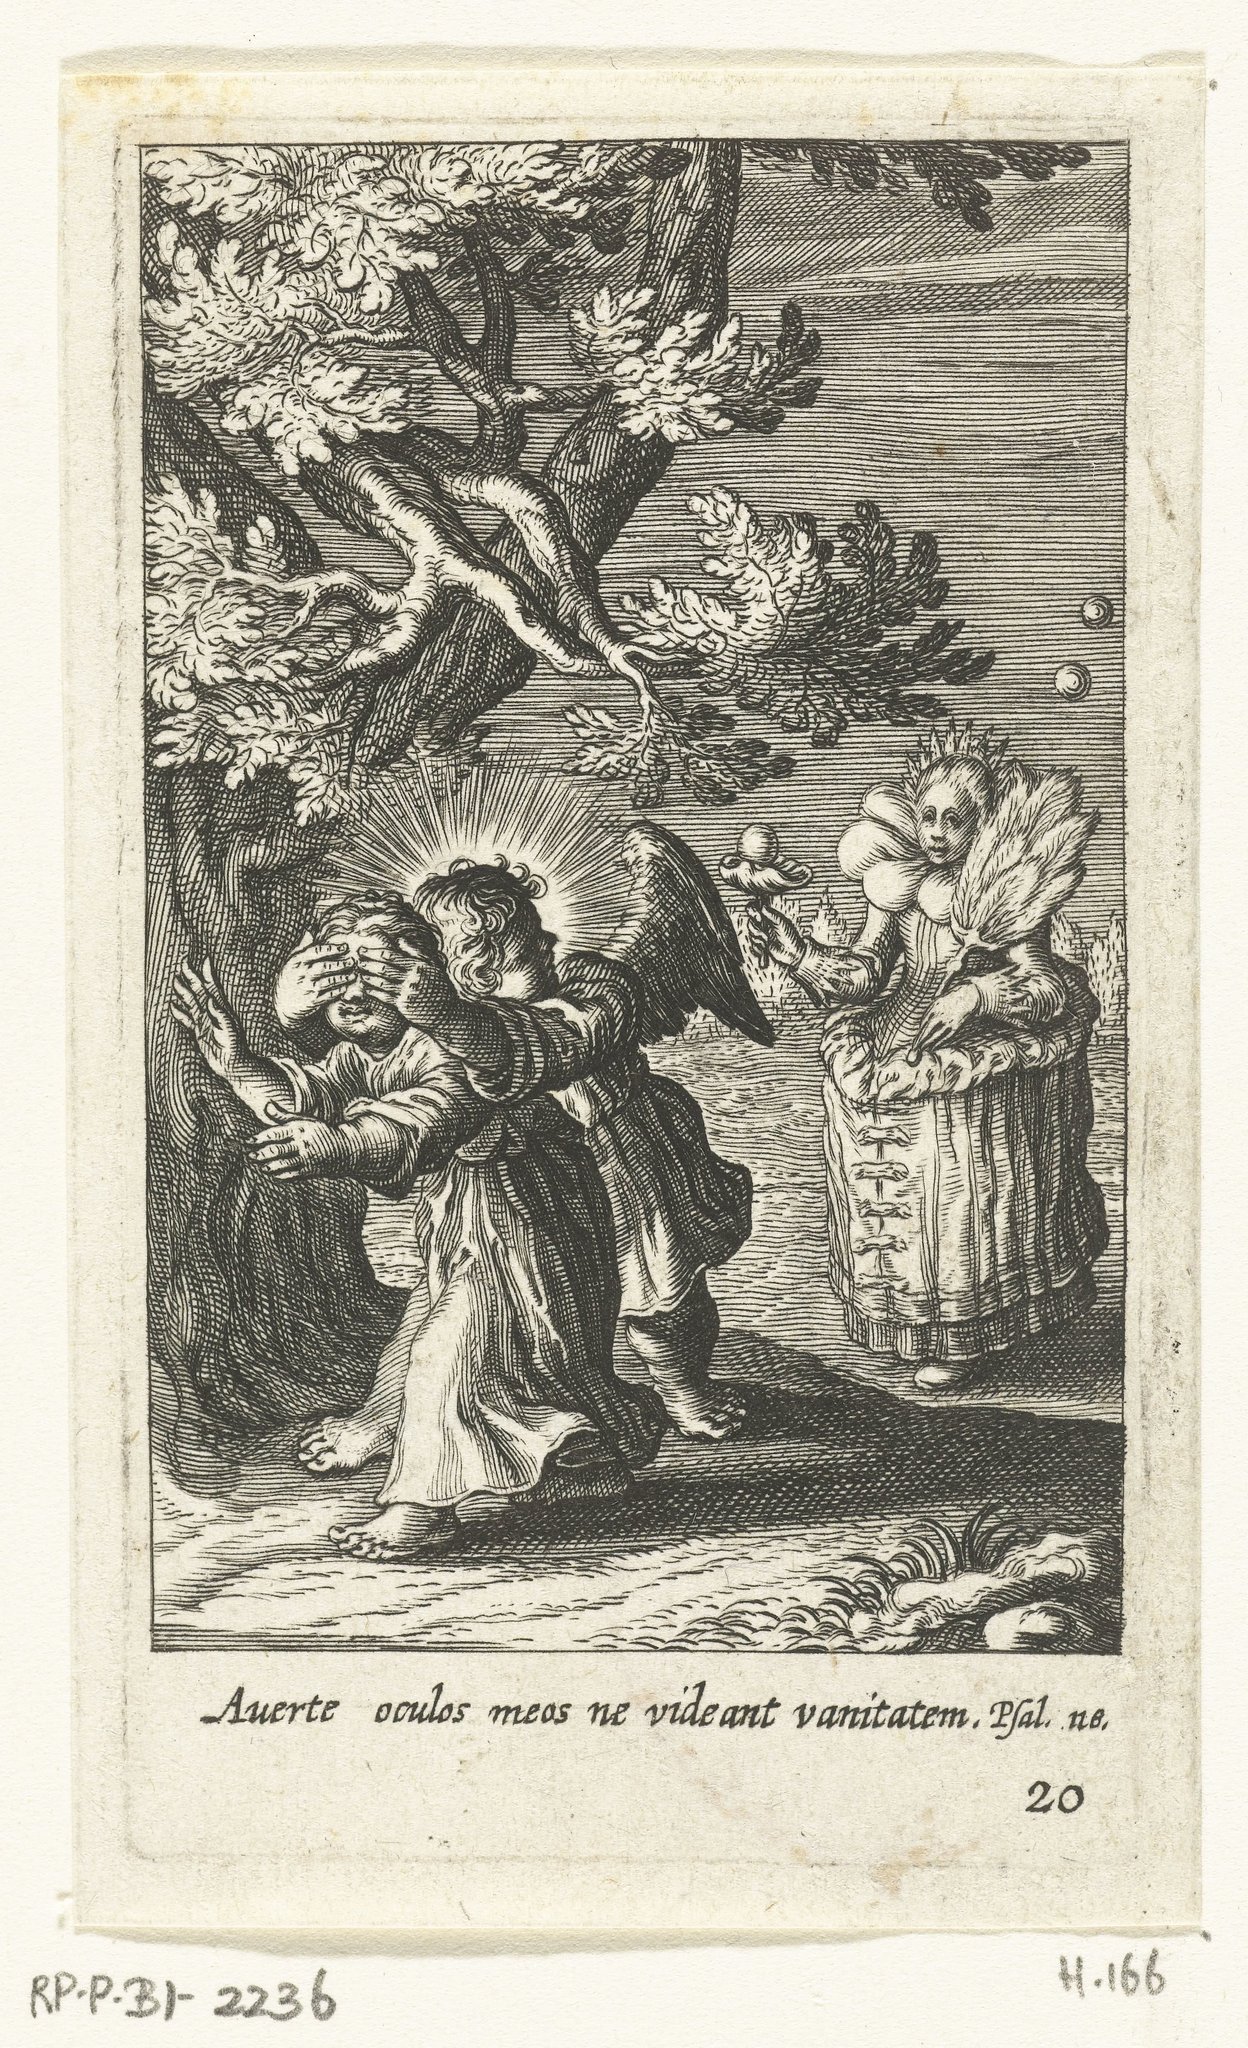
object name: book illustration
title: Pia desideria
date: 1590-1624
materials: paper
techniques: engraving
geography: antwerp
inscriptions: inscription: ‘Auerte oculos meos ne videant vanitatem’, collector's mark: Lugt 240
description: Boekillustratie uit: Herman Hugo, Pia desideria emblematis, elegiis & affectibus S. S. Patrum illustrata, Antwerpen 1624, afb. 20